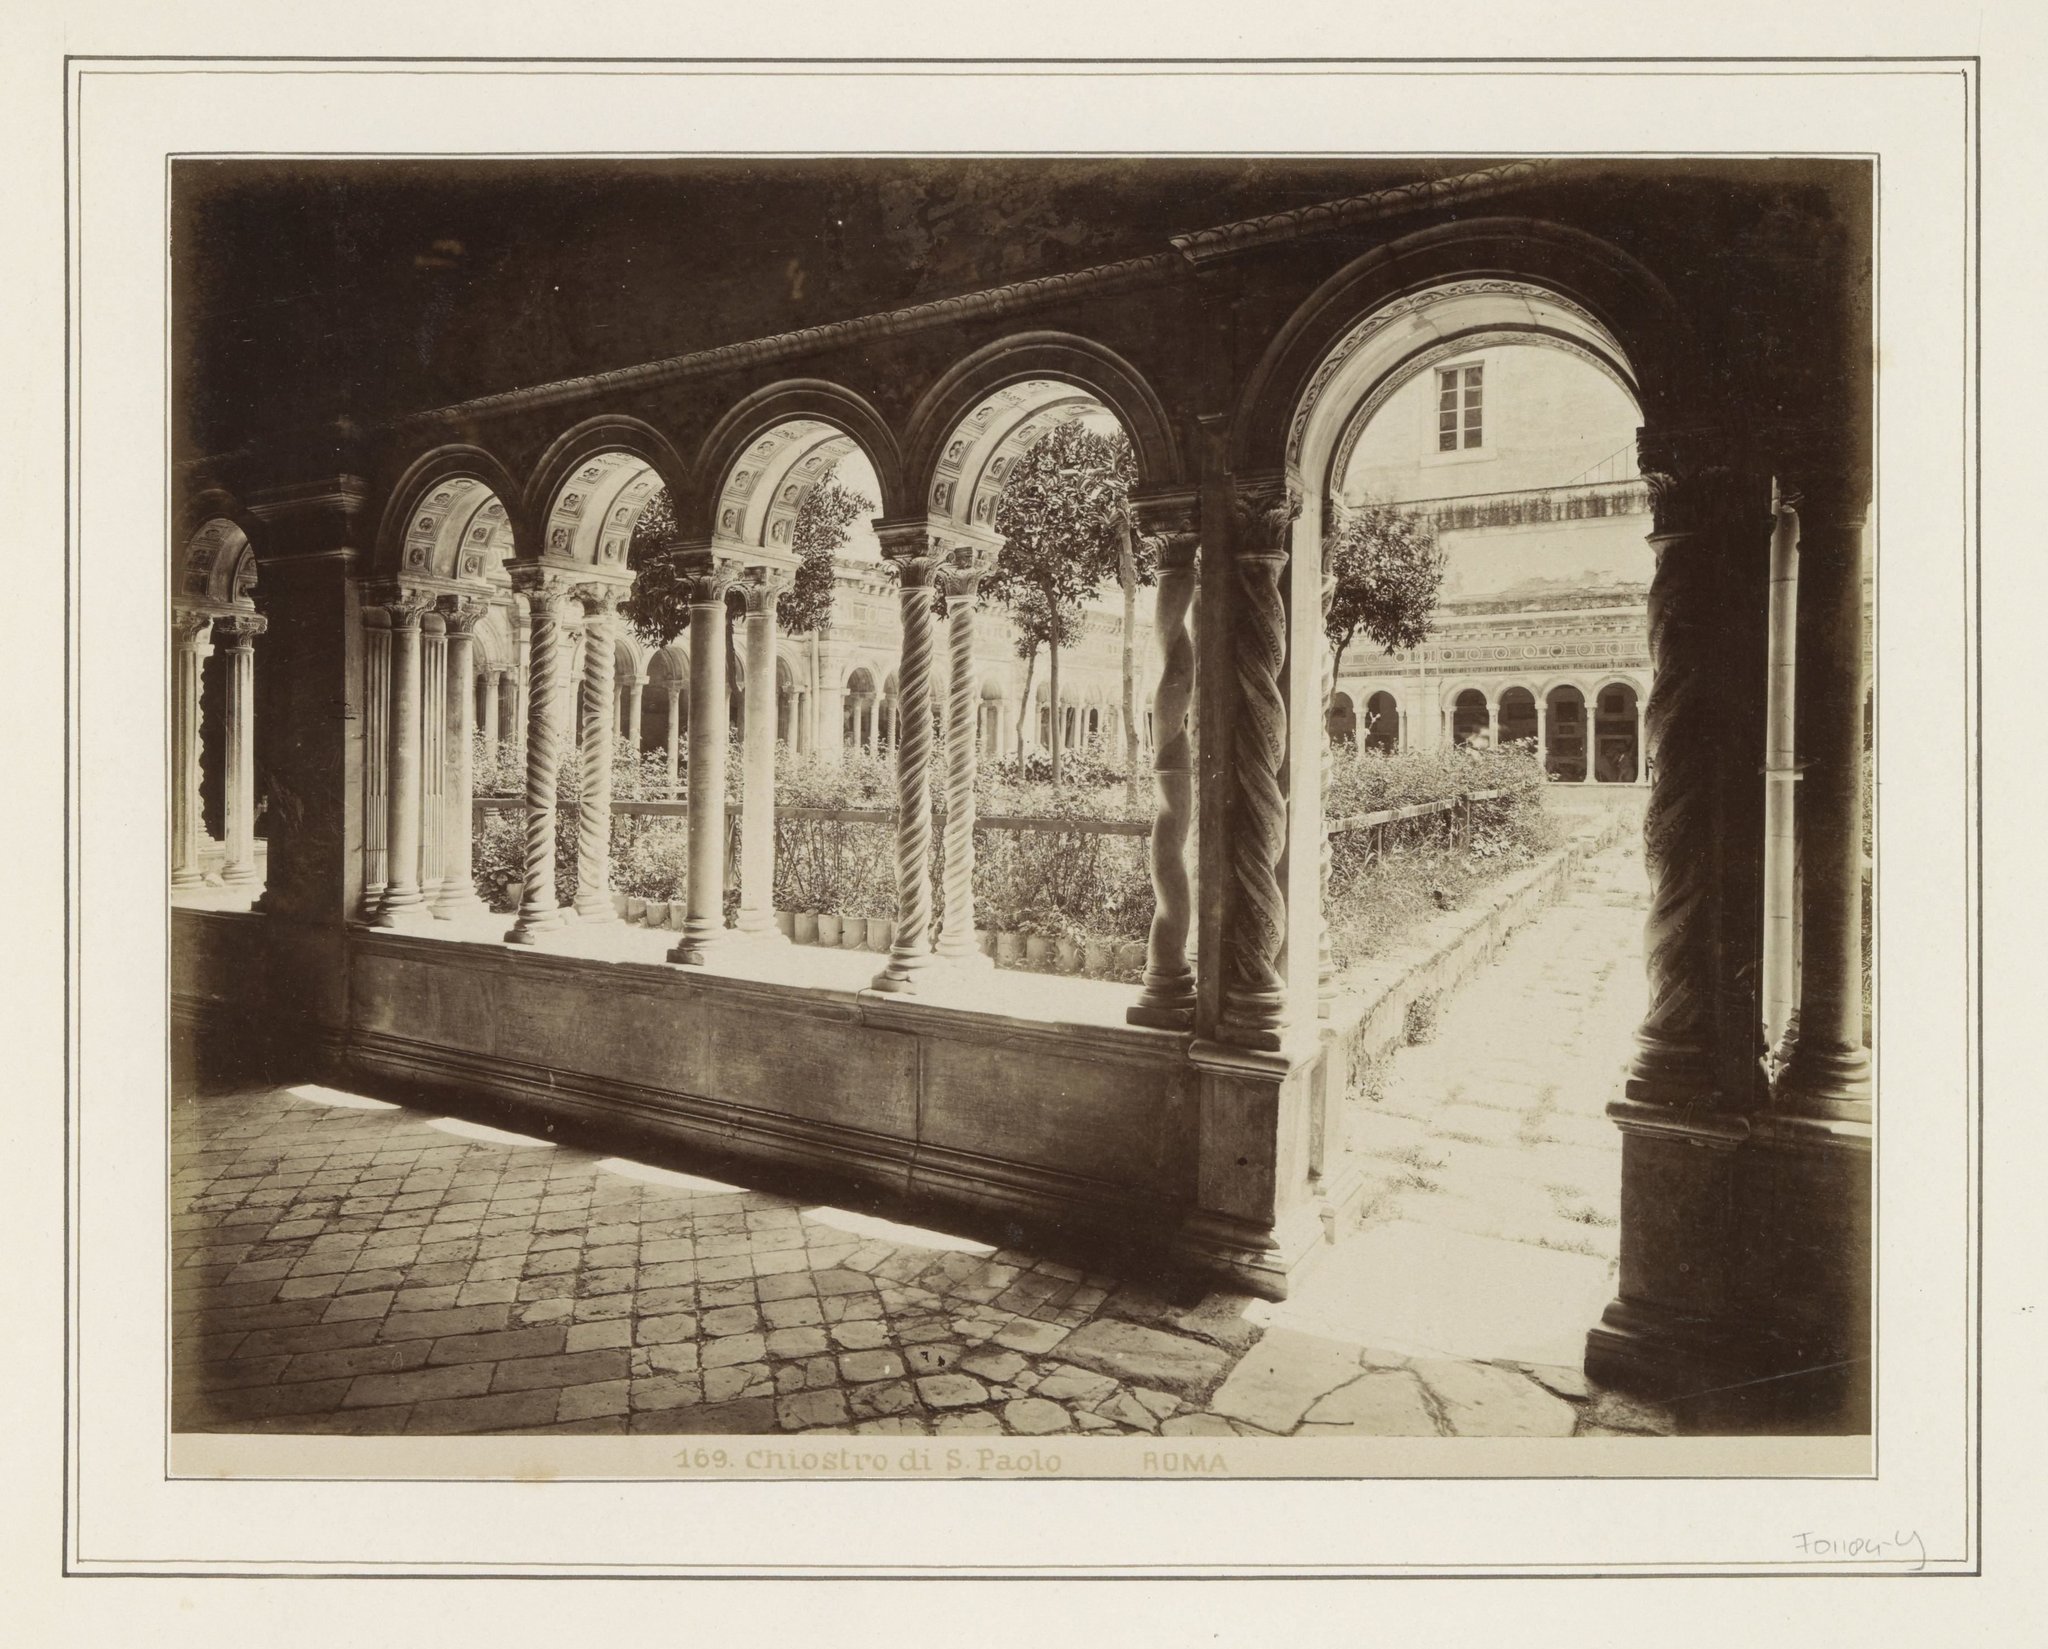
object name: photograph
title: Chiostro di S. Paolo ROMA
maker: Anonymous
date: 1865-1890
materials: paper, photographic support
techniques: albumen print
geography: sint-paulus buiten de muren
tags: garden, cloisters ~ monastery, rome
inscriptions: negative number: ‘169’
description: Onderdeel van Reisalbum met foto's van bezienswaardigheden in Italië (deel I).